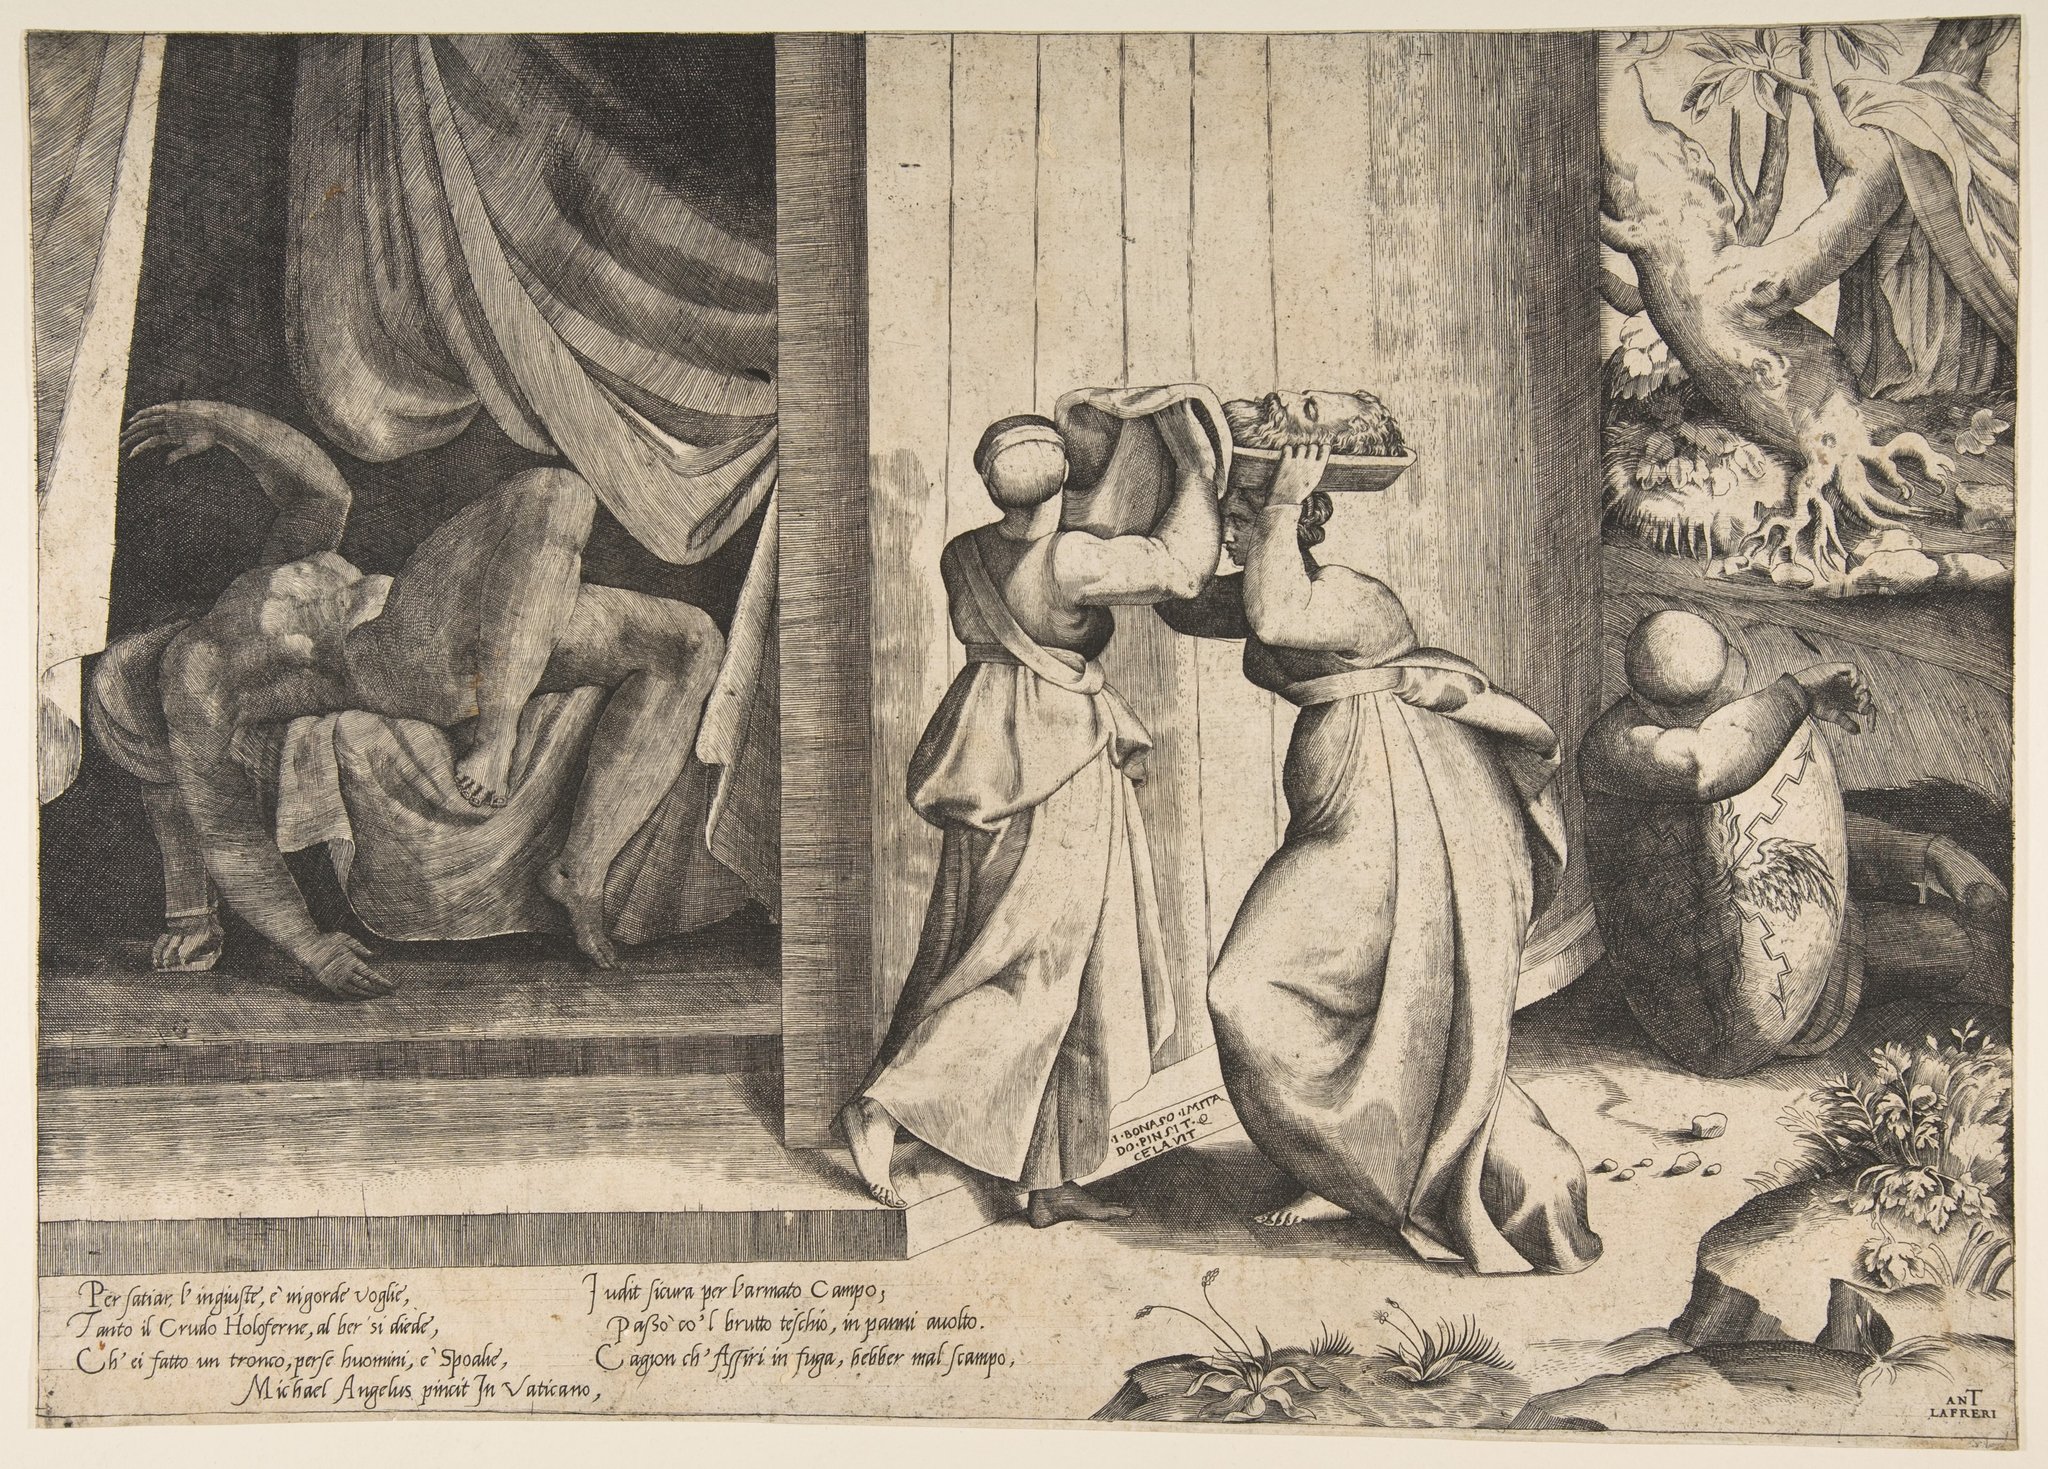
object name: print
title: Judith passing the head of Holofernes to her maidservant, the decapitated Holofernes inside the tent at left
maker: giulio bonasone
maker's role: artist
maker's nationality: italian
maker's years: 1510-1576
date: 1531-1576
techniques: engraving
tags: corpses,heads,women,holofernes,judith